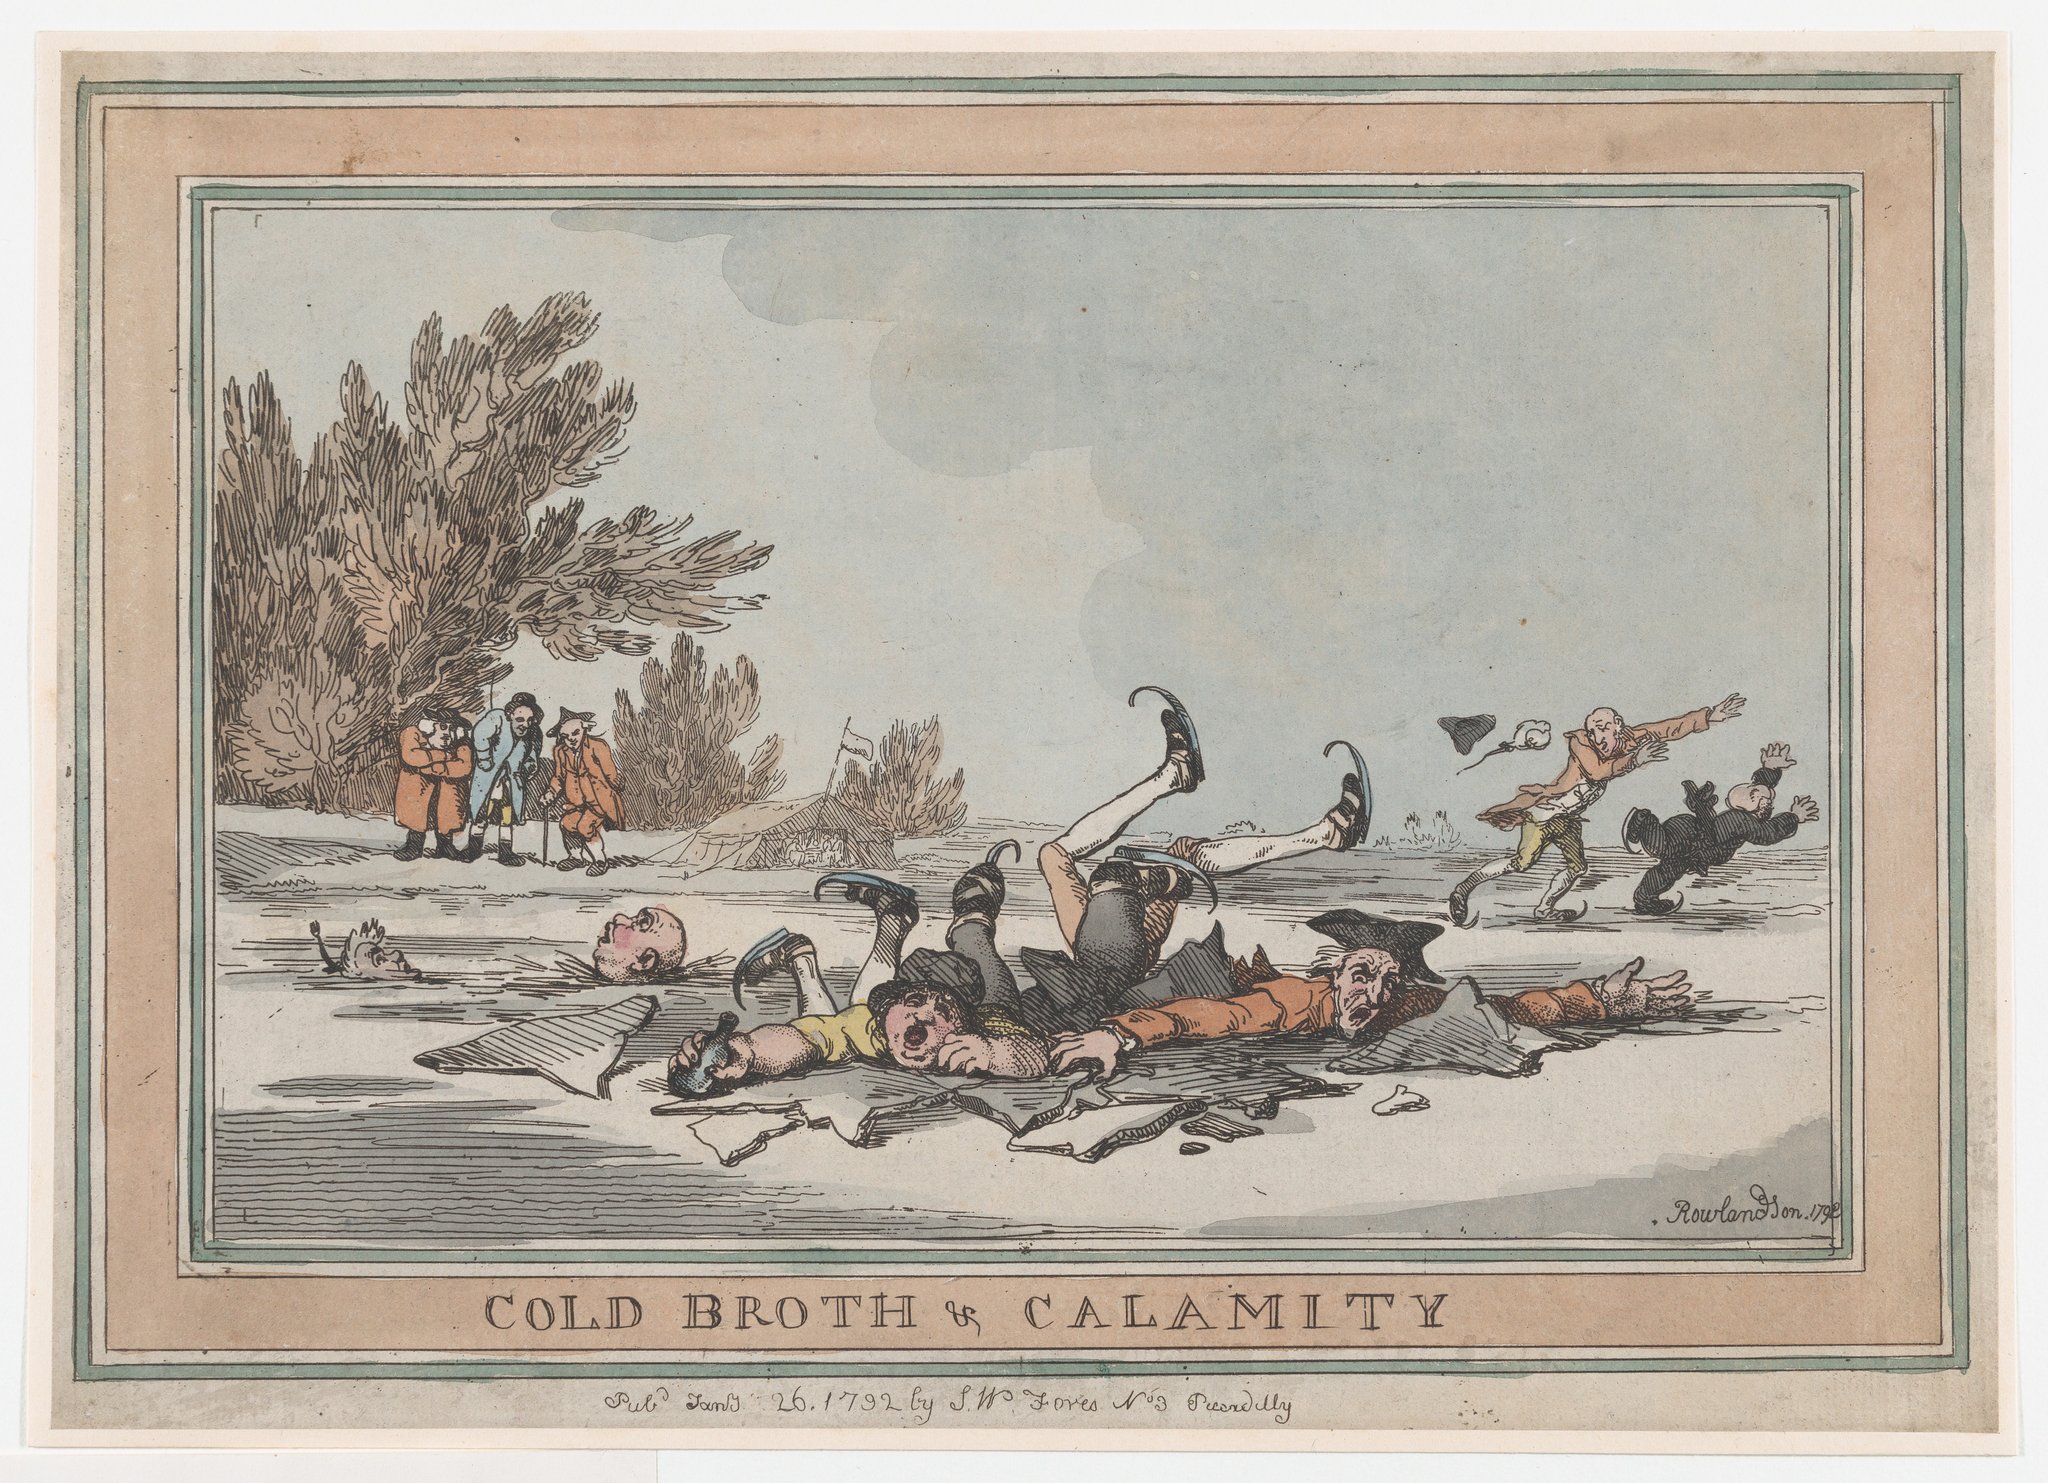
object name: print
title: Cold Broth & Calamity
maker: thomas rowlandson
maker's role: artist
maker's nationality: british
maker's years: 1757-1827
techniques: etching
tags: satire,men,skating